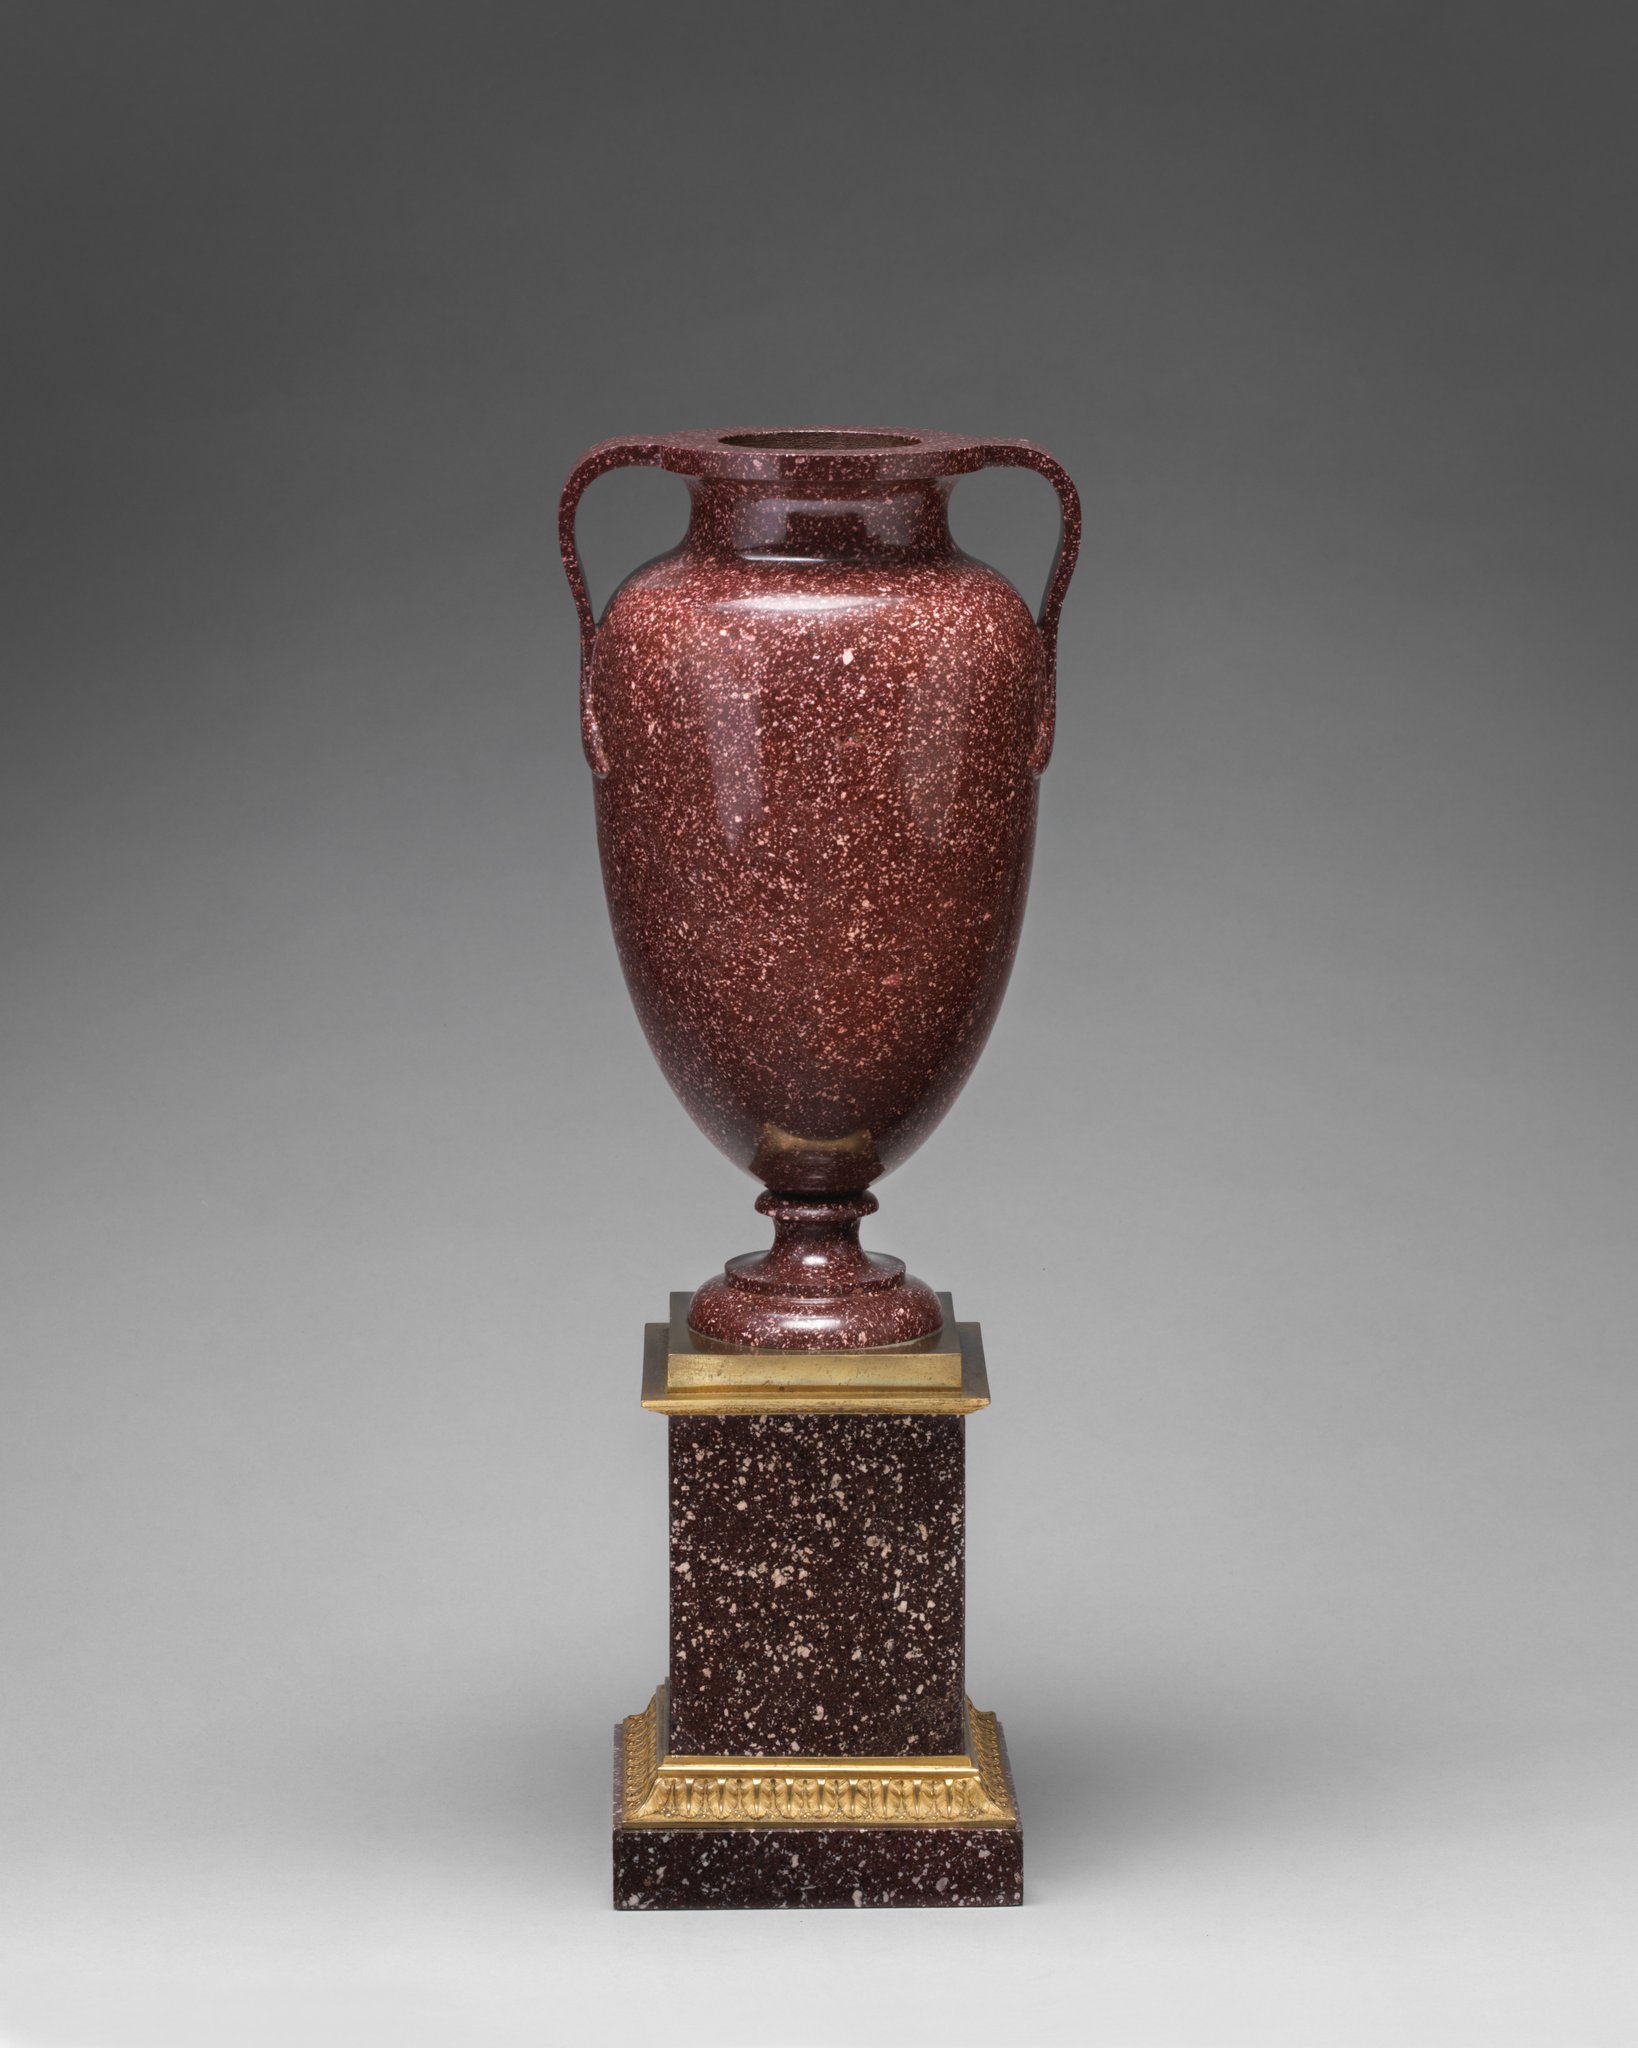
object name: urn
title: Urn on square base (one of a pair)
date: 1770-1780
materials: gilt bronze